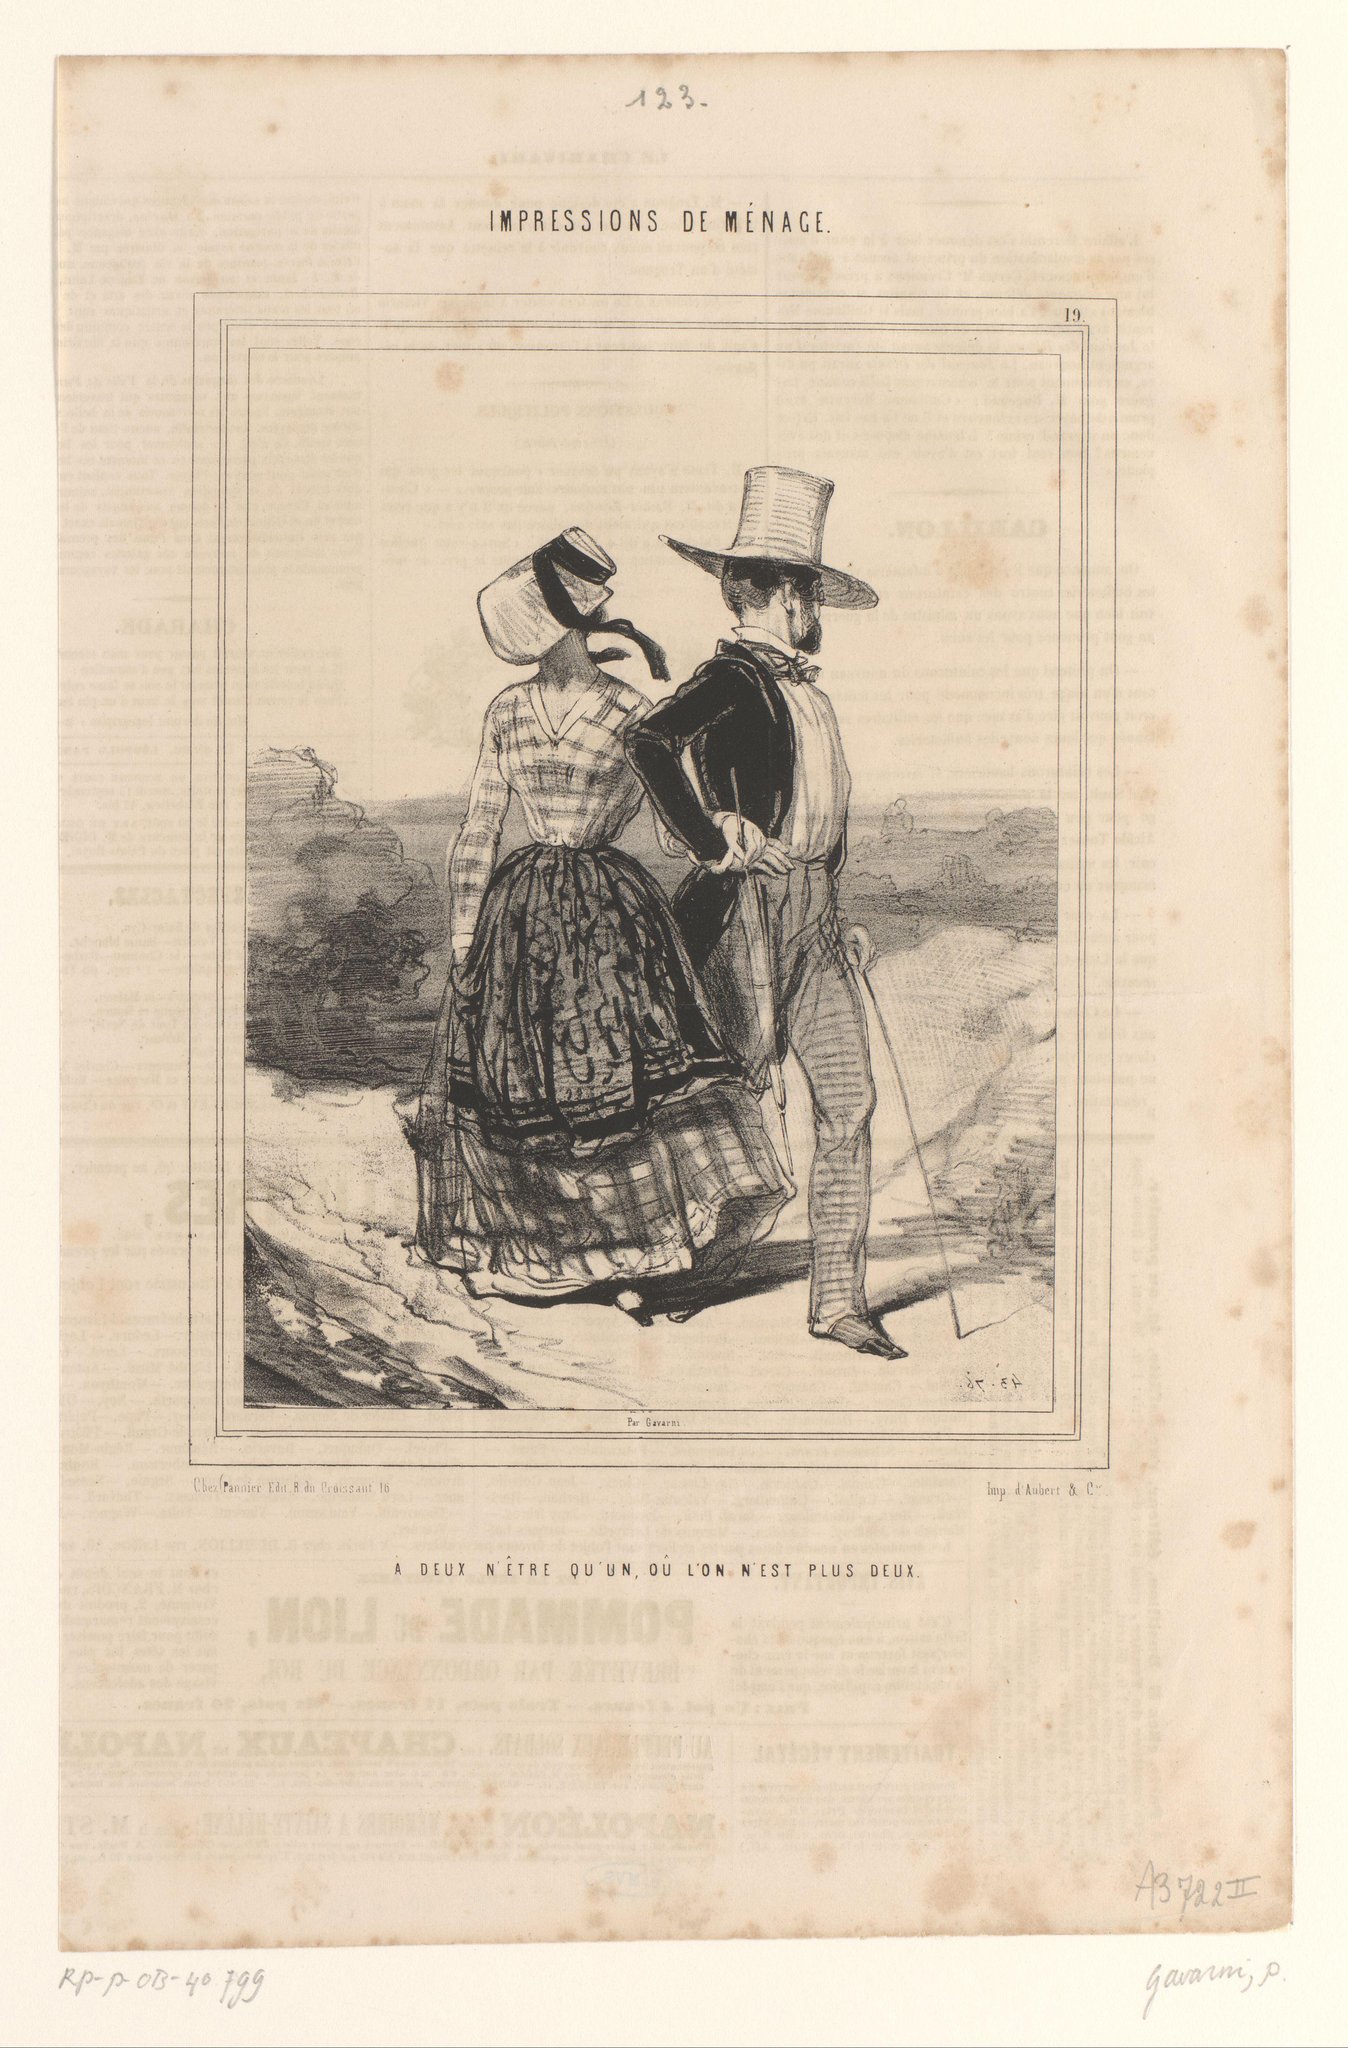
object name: print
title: Impressies van het huwelijk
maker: paul gavarni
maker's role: draughtsman, print maker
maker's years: 1804-1866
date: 1843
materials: paper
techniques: lithograph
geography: paris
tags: walking, hiking (recreation), satire on marriage, arm in arm (lovers)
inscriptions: collector's mark: Lugt 2228a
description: De man en vrouw vormen weliswaar een eenheid; ze kijken allebei een andere kant op.